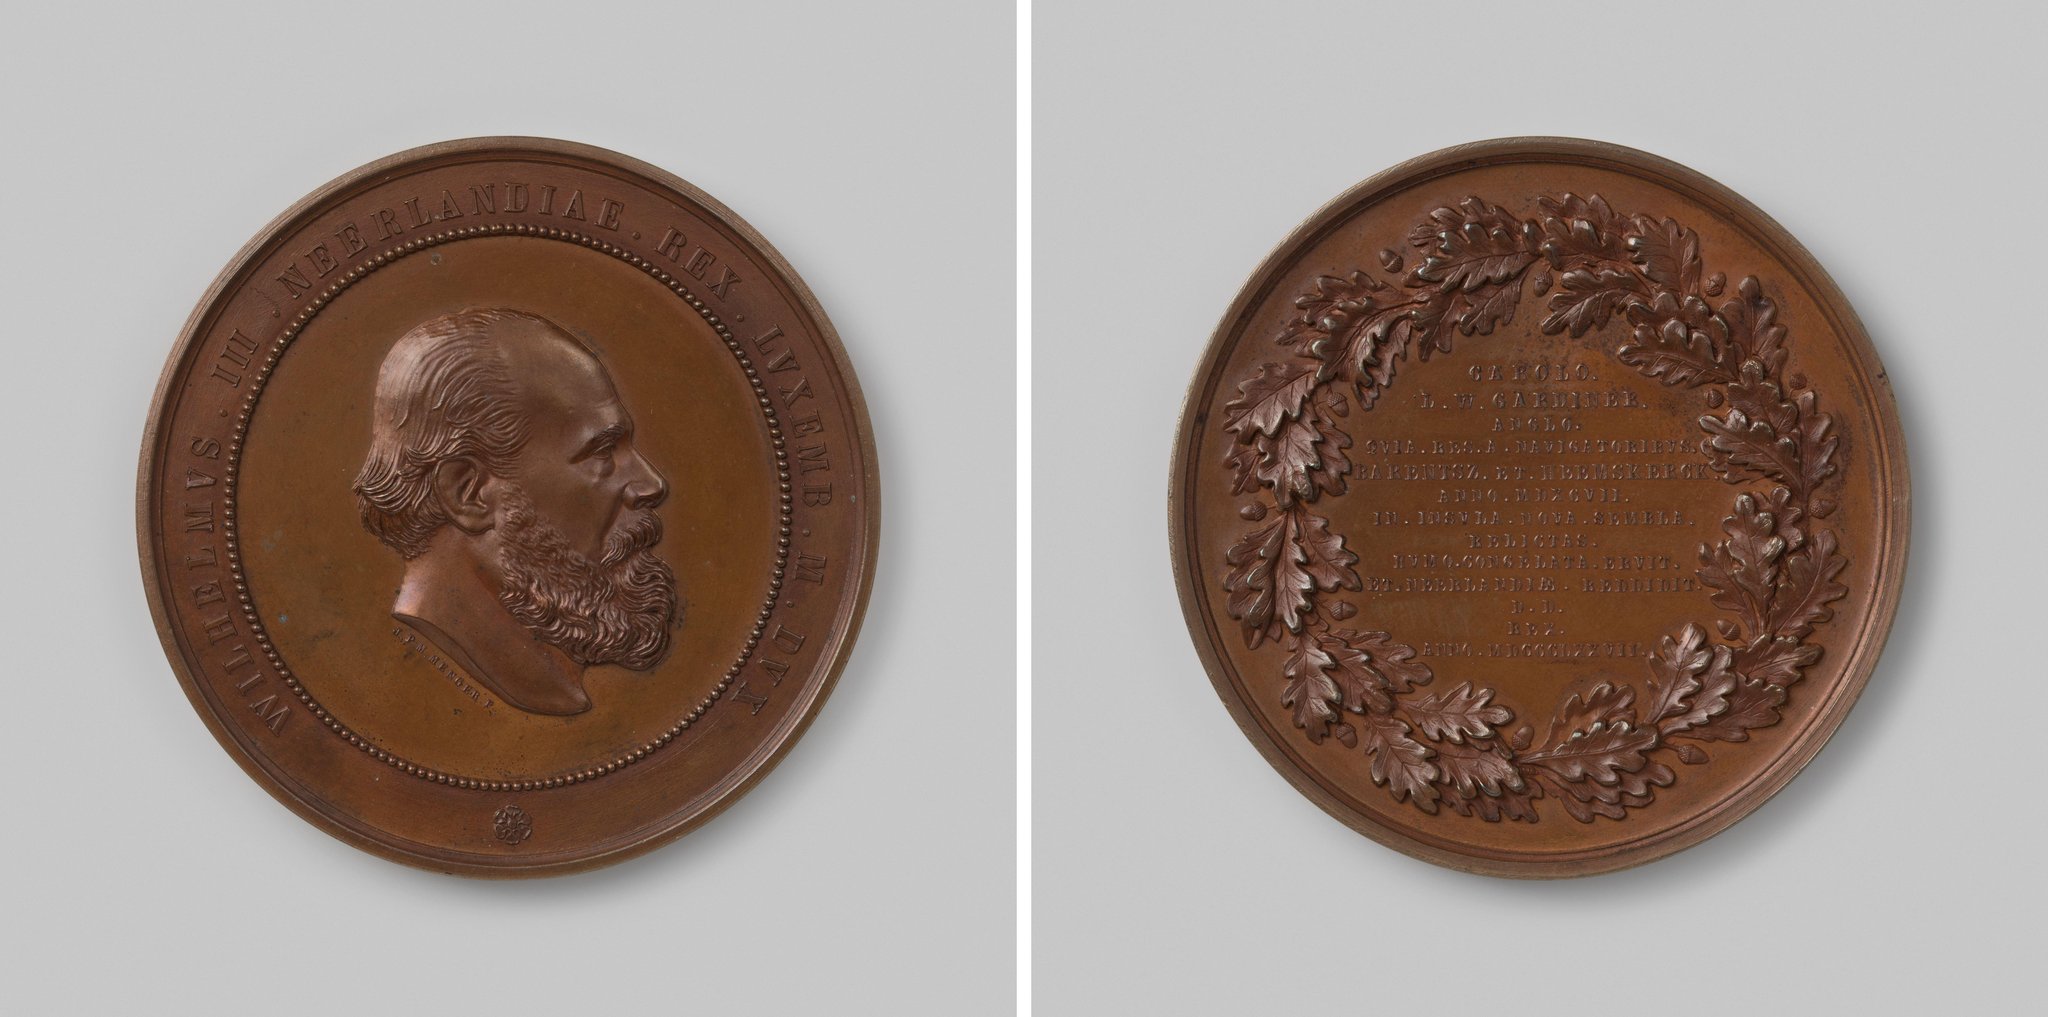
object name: medal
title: Penning geschonken aan C.L.W. Gardiner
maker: johan philip mathias menger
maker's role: medailleur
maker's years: 1845-1905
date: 1877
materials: bronze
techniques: engraving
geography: utrecht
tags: brussels, willem iii (koning der nederlanden)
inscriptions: inscription: ‘CAROLO / L.W. GARDINER / ANGLO / QVIA RES A NAVIGATORIBVS / BARENTSZ ET HEEMSKERCK / ANNO MDXCVII / IN INSVLA NOVA SEMBLA / RELICTAS / HVMO CONGELATA ERVIT / ET NEERLANDIÆ REDDIDIT / D.D. / REX / ANNO MDCCCLXXVII’, signature and date: ‘J.P.M. MENGER F.’, inscription: ‘WILHELMVS . III . NEERLANDIAE . REX . LVXEMB . M . DVX.’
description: Bronzen penning, origineel van goud werd aan hem verleend voor het afstaan van voorwerpen door hem op Nova Zembla gevonden. Voorzijde: portret van een man, Z.M. Koning Willem III, naar rechts kijkend met baard in relief.